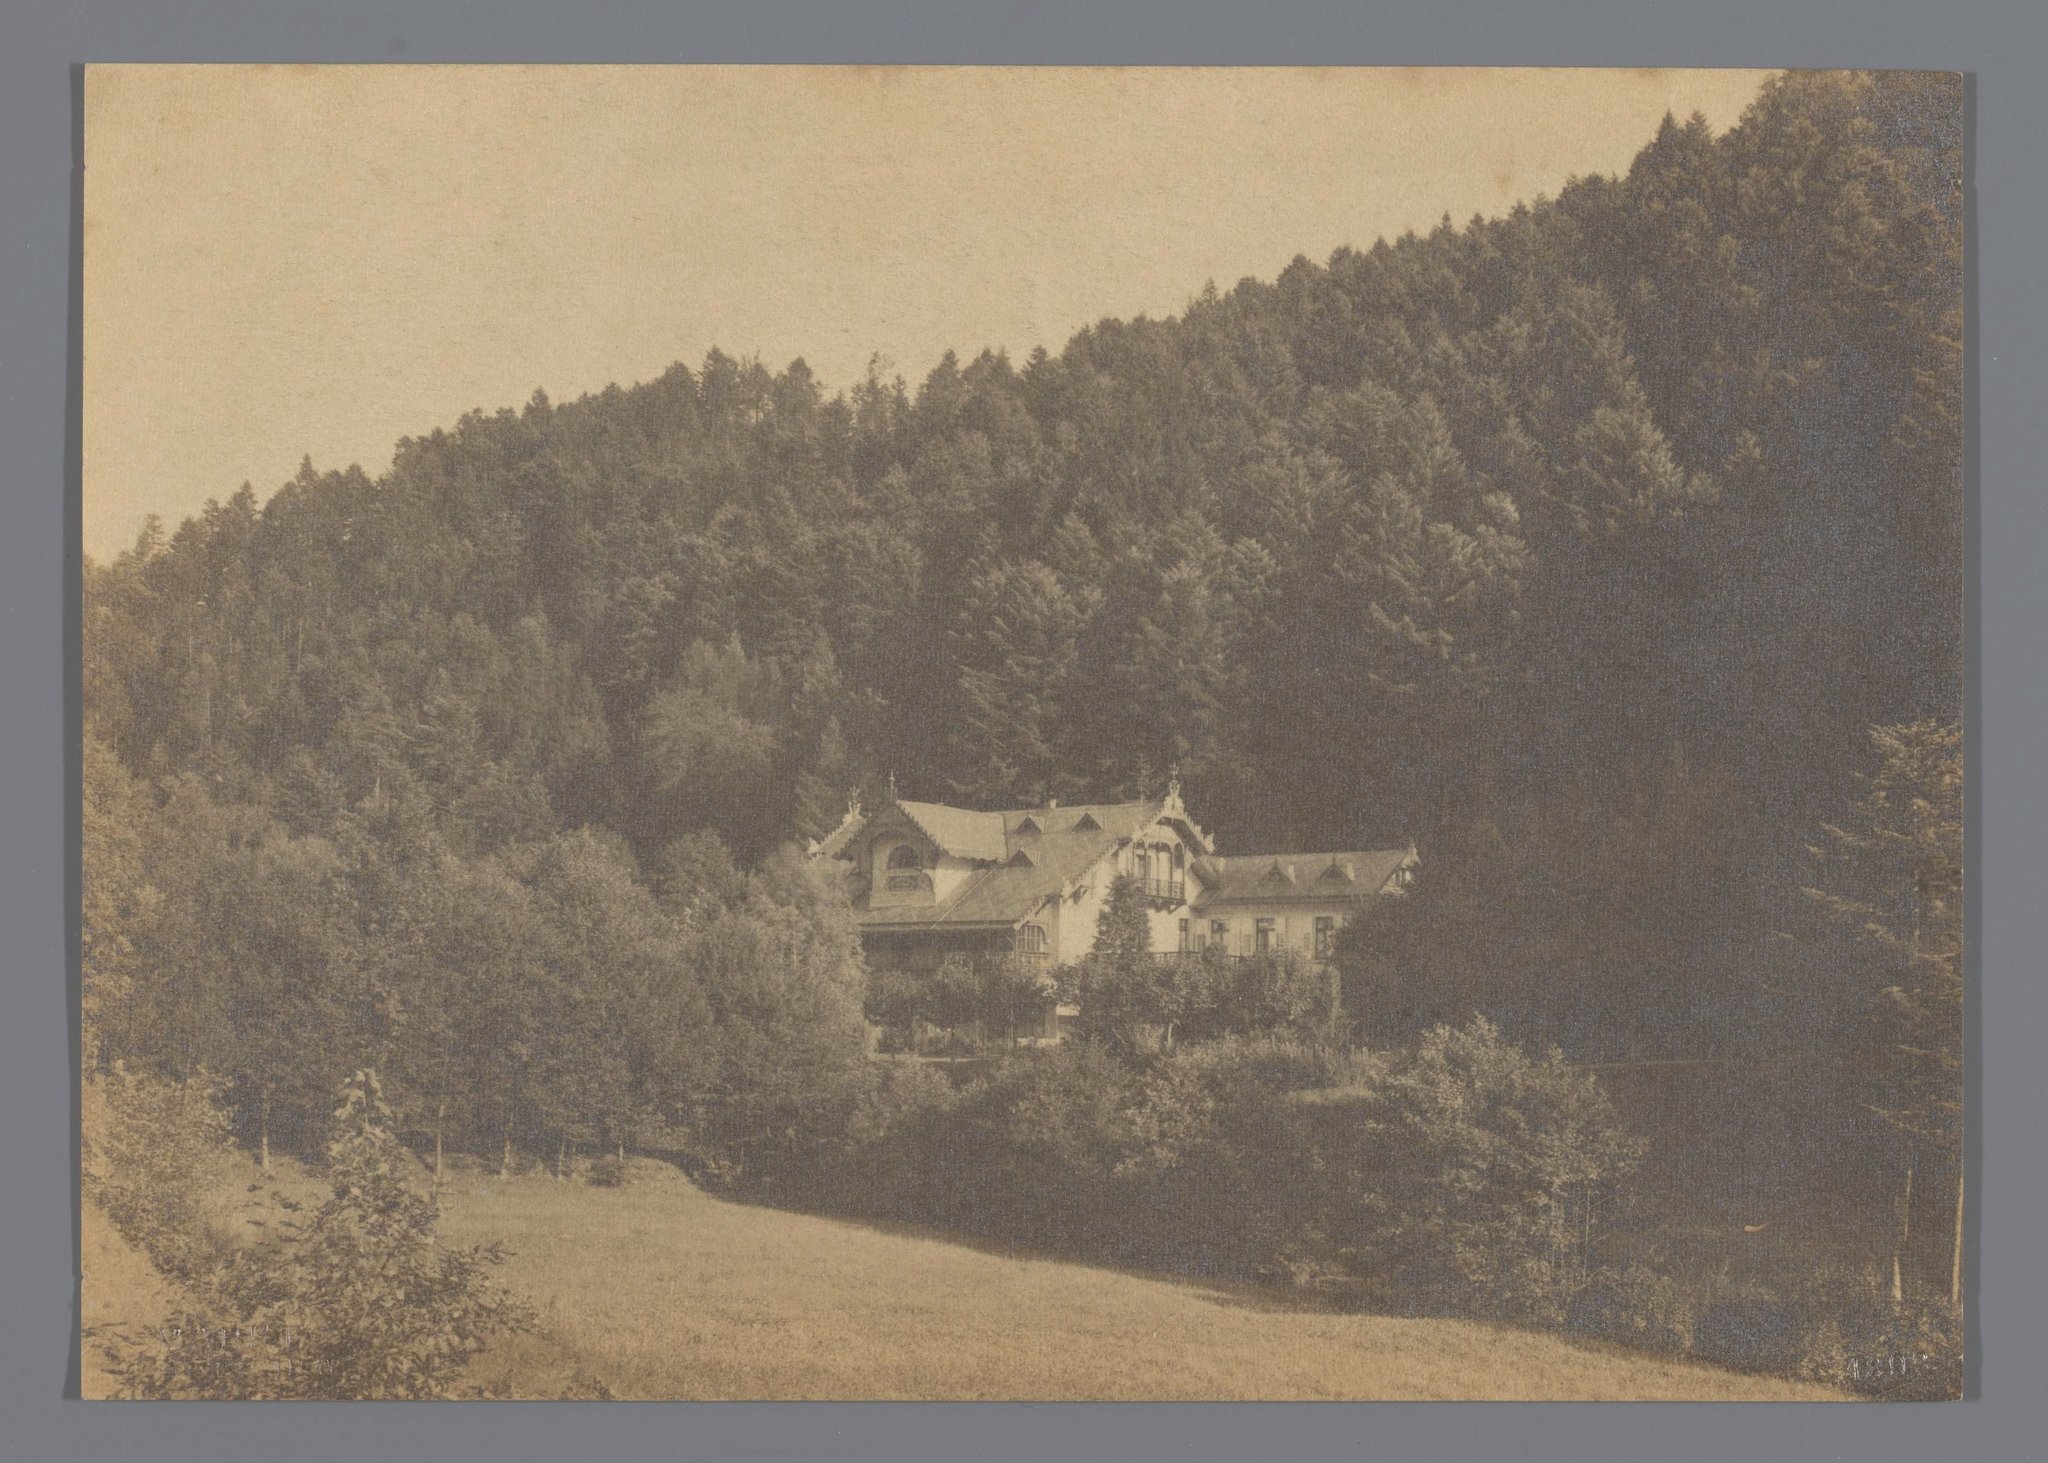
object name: photograph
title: Gezicht op landhuis 'Fischkultur' in Baden-Baden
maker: charles markt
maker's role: fotograaf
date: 1893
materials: paper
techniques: gelatin silver print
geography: baden-baden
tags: rural housing, e.g. country-house, villa, cottage, forest, wood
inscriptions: inscription: ‘Fischcultur/ Baden-Baden/ 1893-'94-'95/ 225’, check stamp: ‘Markt/ Baden-Baden’, collector's mark: ‘Vosmaer’